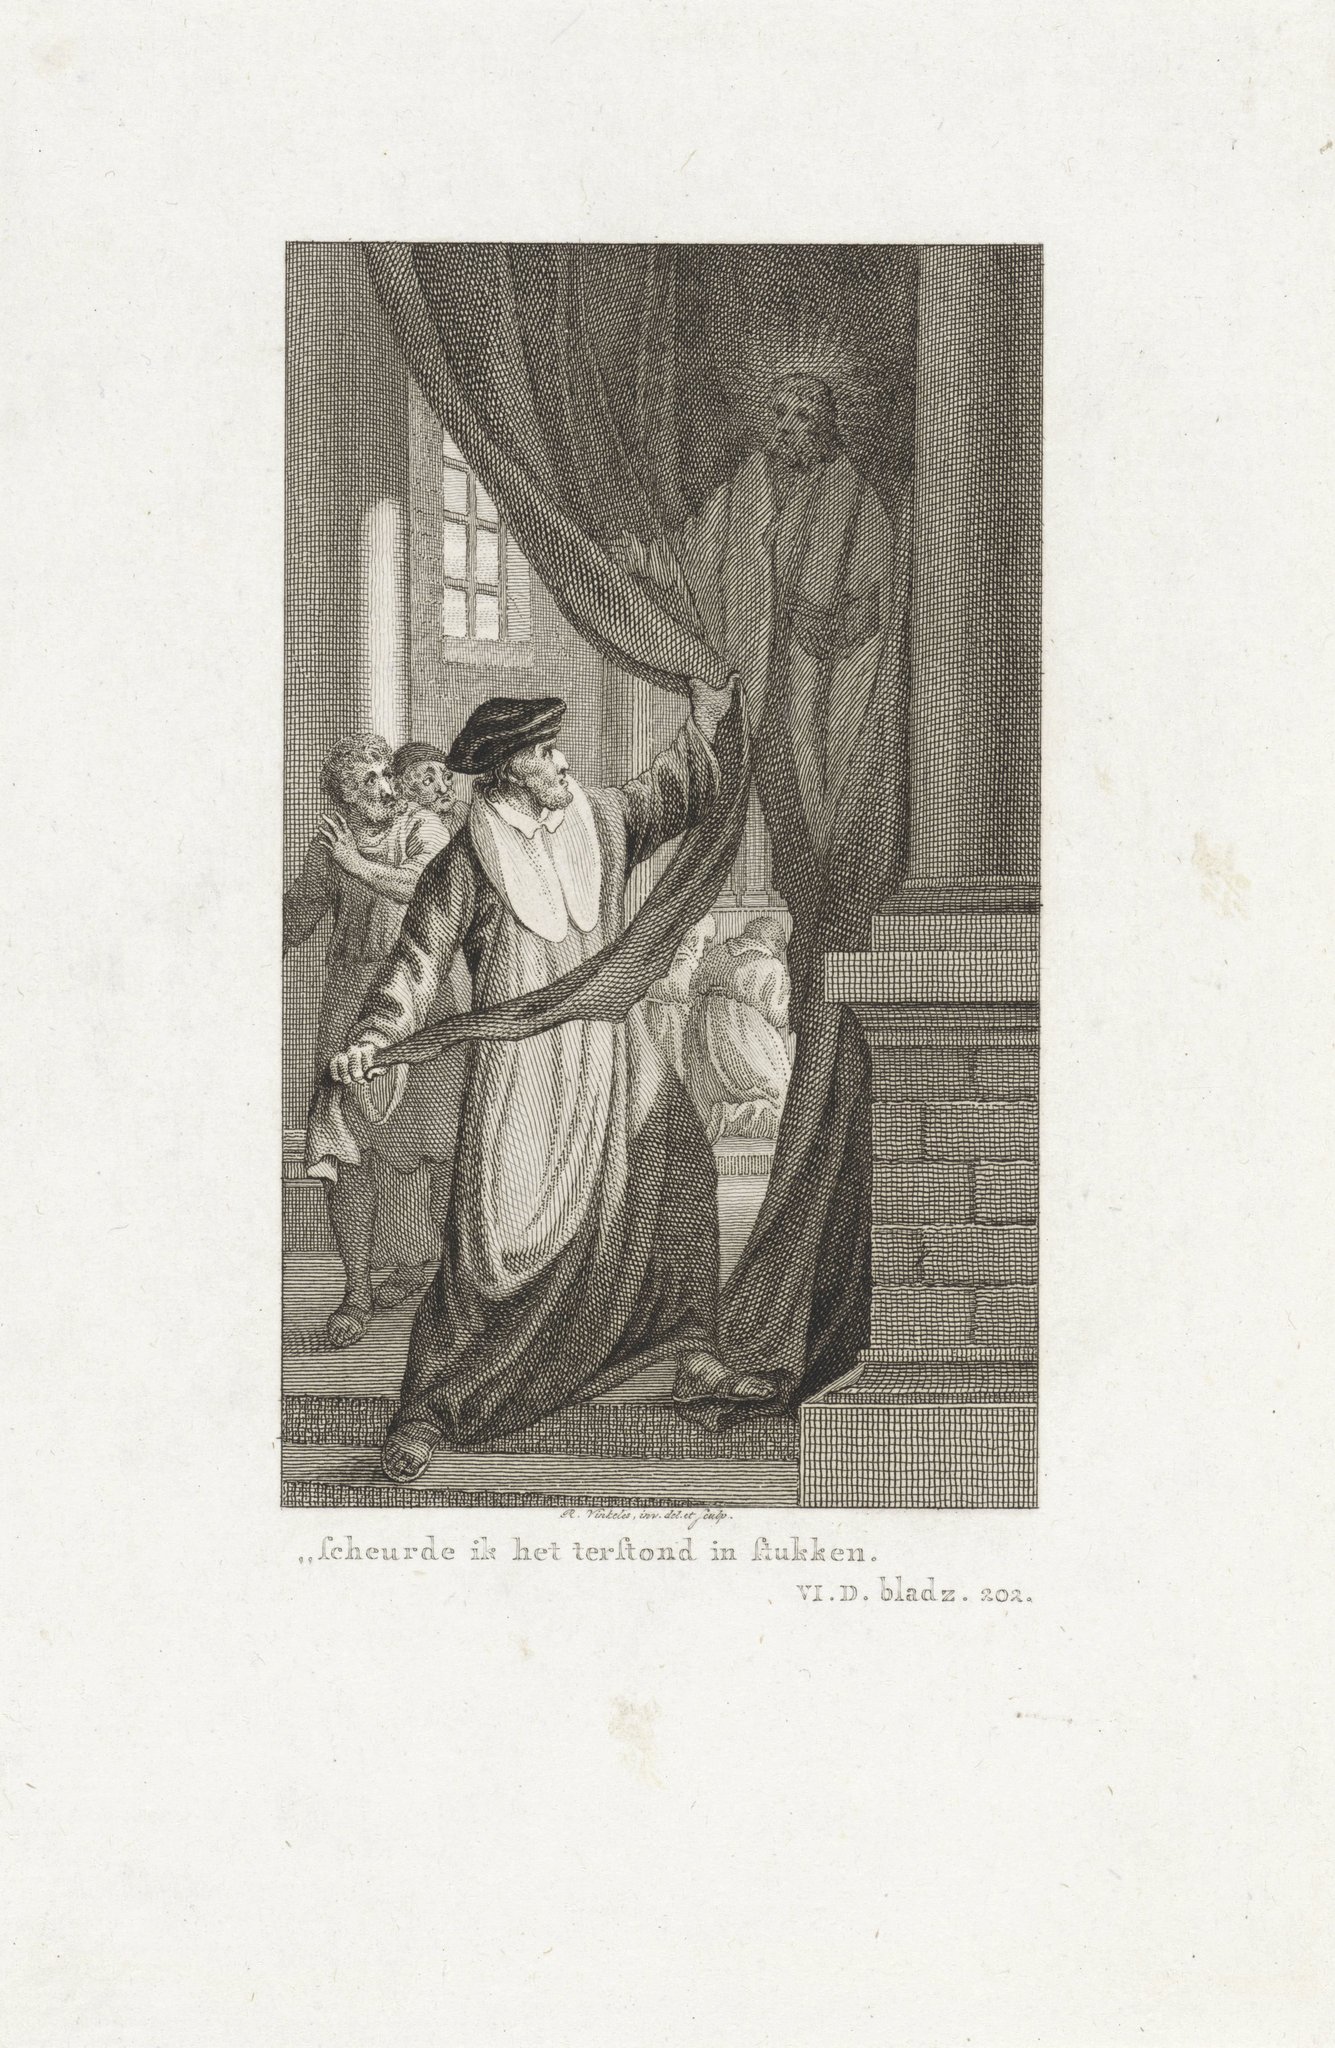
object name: print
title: Epifanius staat op het punt om een beeld van Christus te vernietigen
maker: reinier vinkeles (i)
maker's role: draughtsman, print maker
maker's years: 1741-1816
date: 1803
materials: paper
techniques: engraving, etching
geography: amsterdam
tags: curtains, destruction of monuments, portraits, etc. (~ revolution), interior of church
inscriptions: collector's mark: Lugt 240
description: Illustratie in: Hamelsveld, Ysbrand van. Algemeene kerkelijke geschiedenis, der Christenen, deel 6. Haarlem: François Bohn, 1803, p. 202.